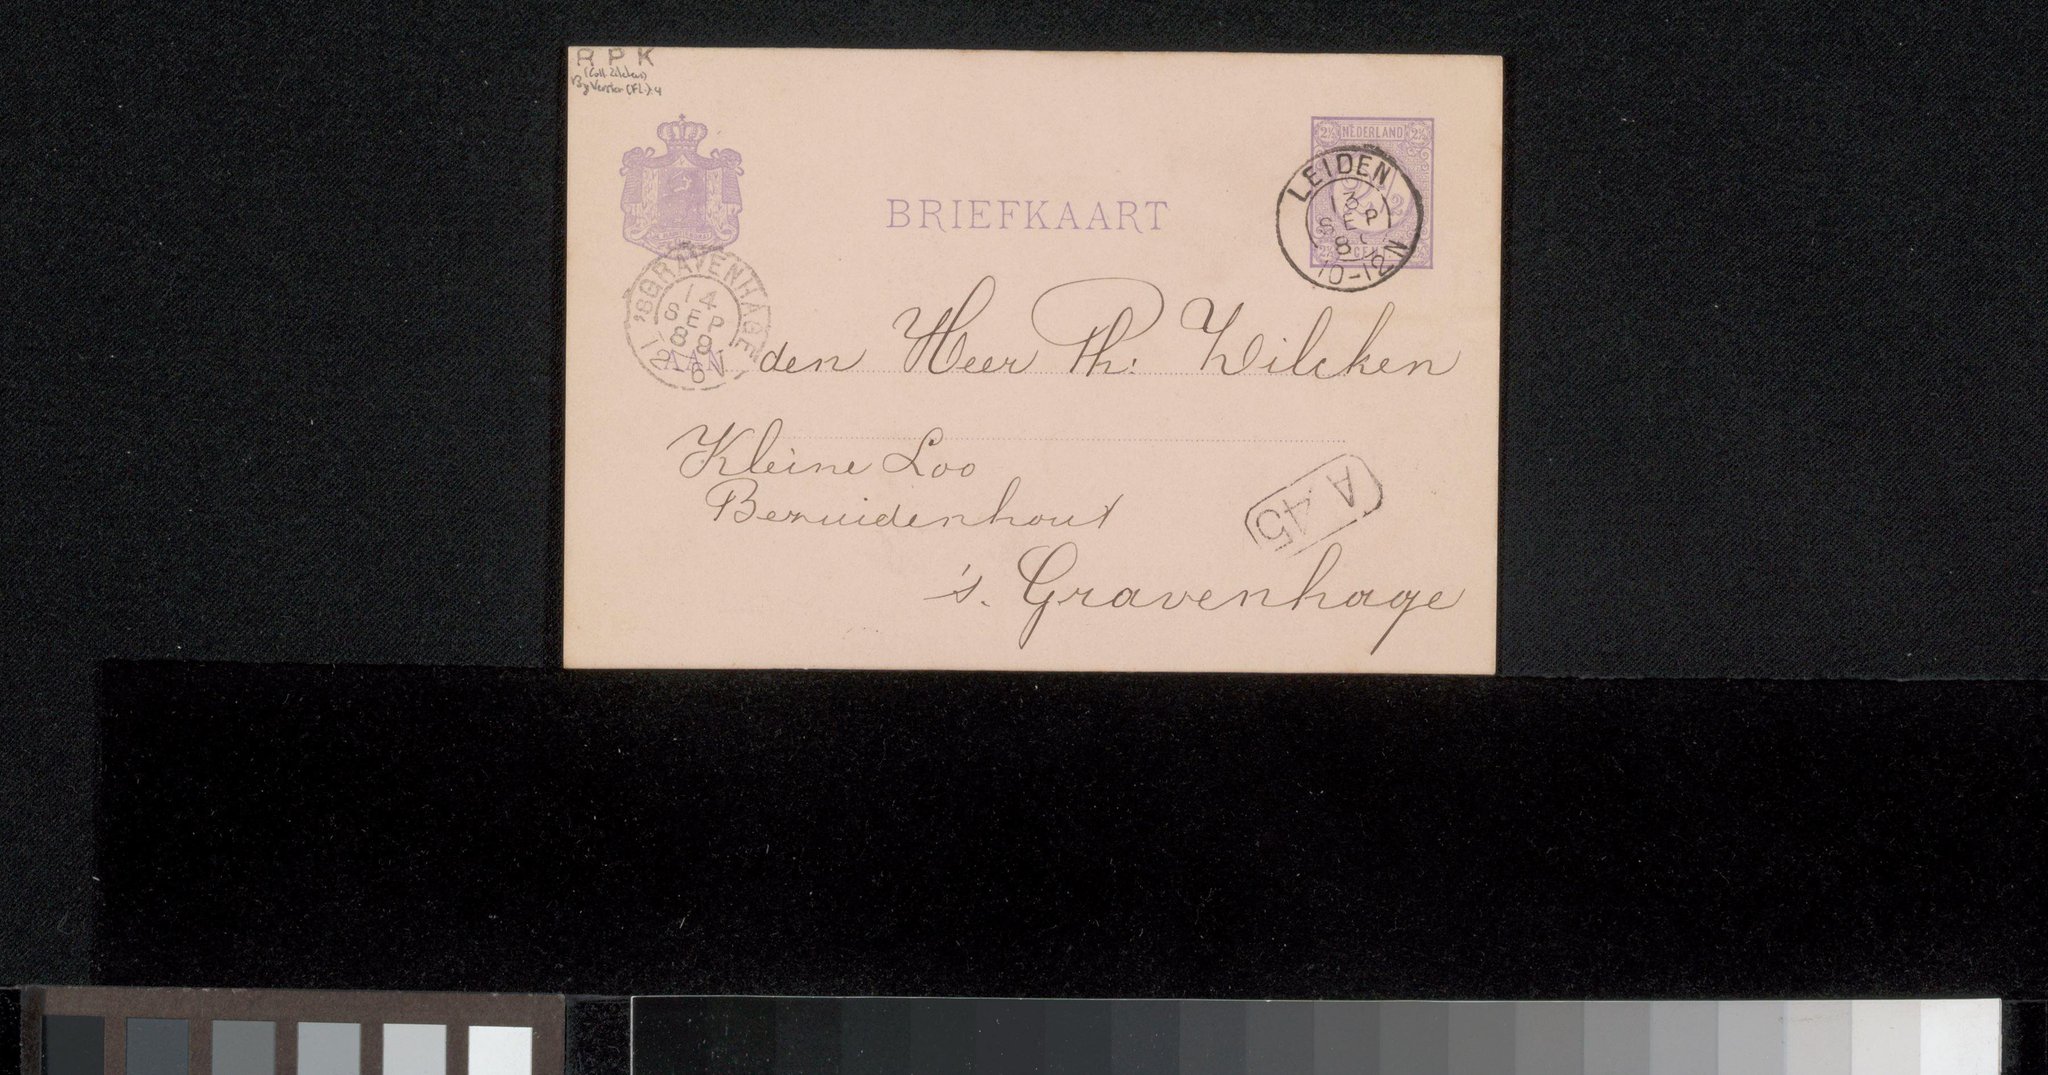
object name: postcard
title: Briefkaart aan Philip Zilcken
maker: floris verster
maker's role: draughtsman, painter, print maker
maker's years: 1861-1927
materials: cardboard, ink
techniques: pen, writing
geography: leiden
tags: the hague, painter, print maker, draughtsman, hendrik willem mesdag, philip zilcken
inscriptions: collector's mark: ‘RPK’